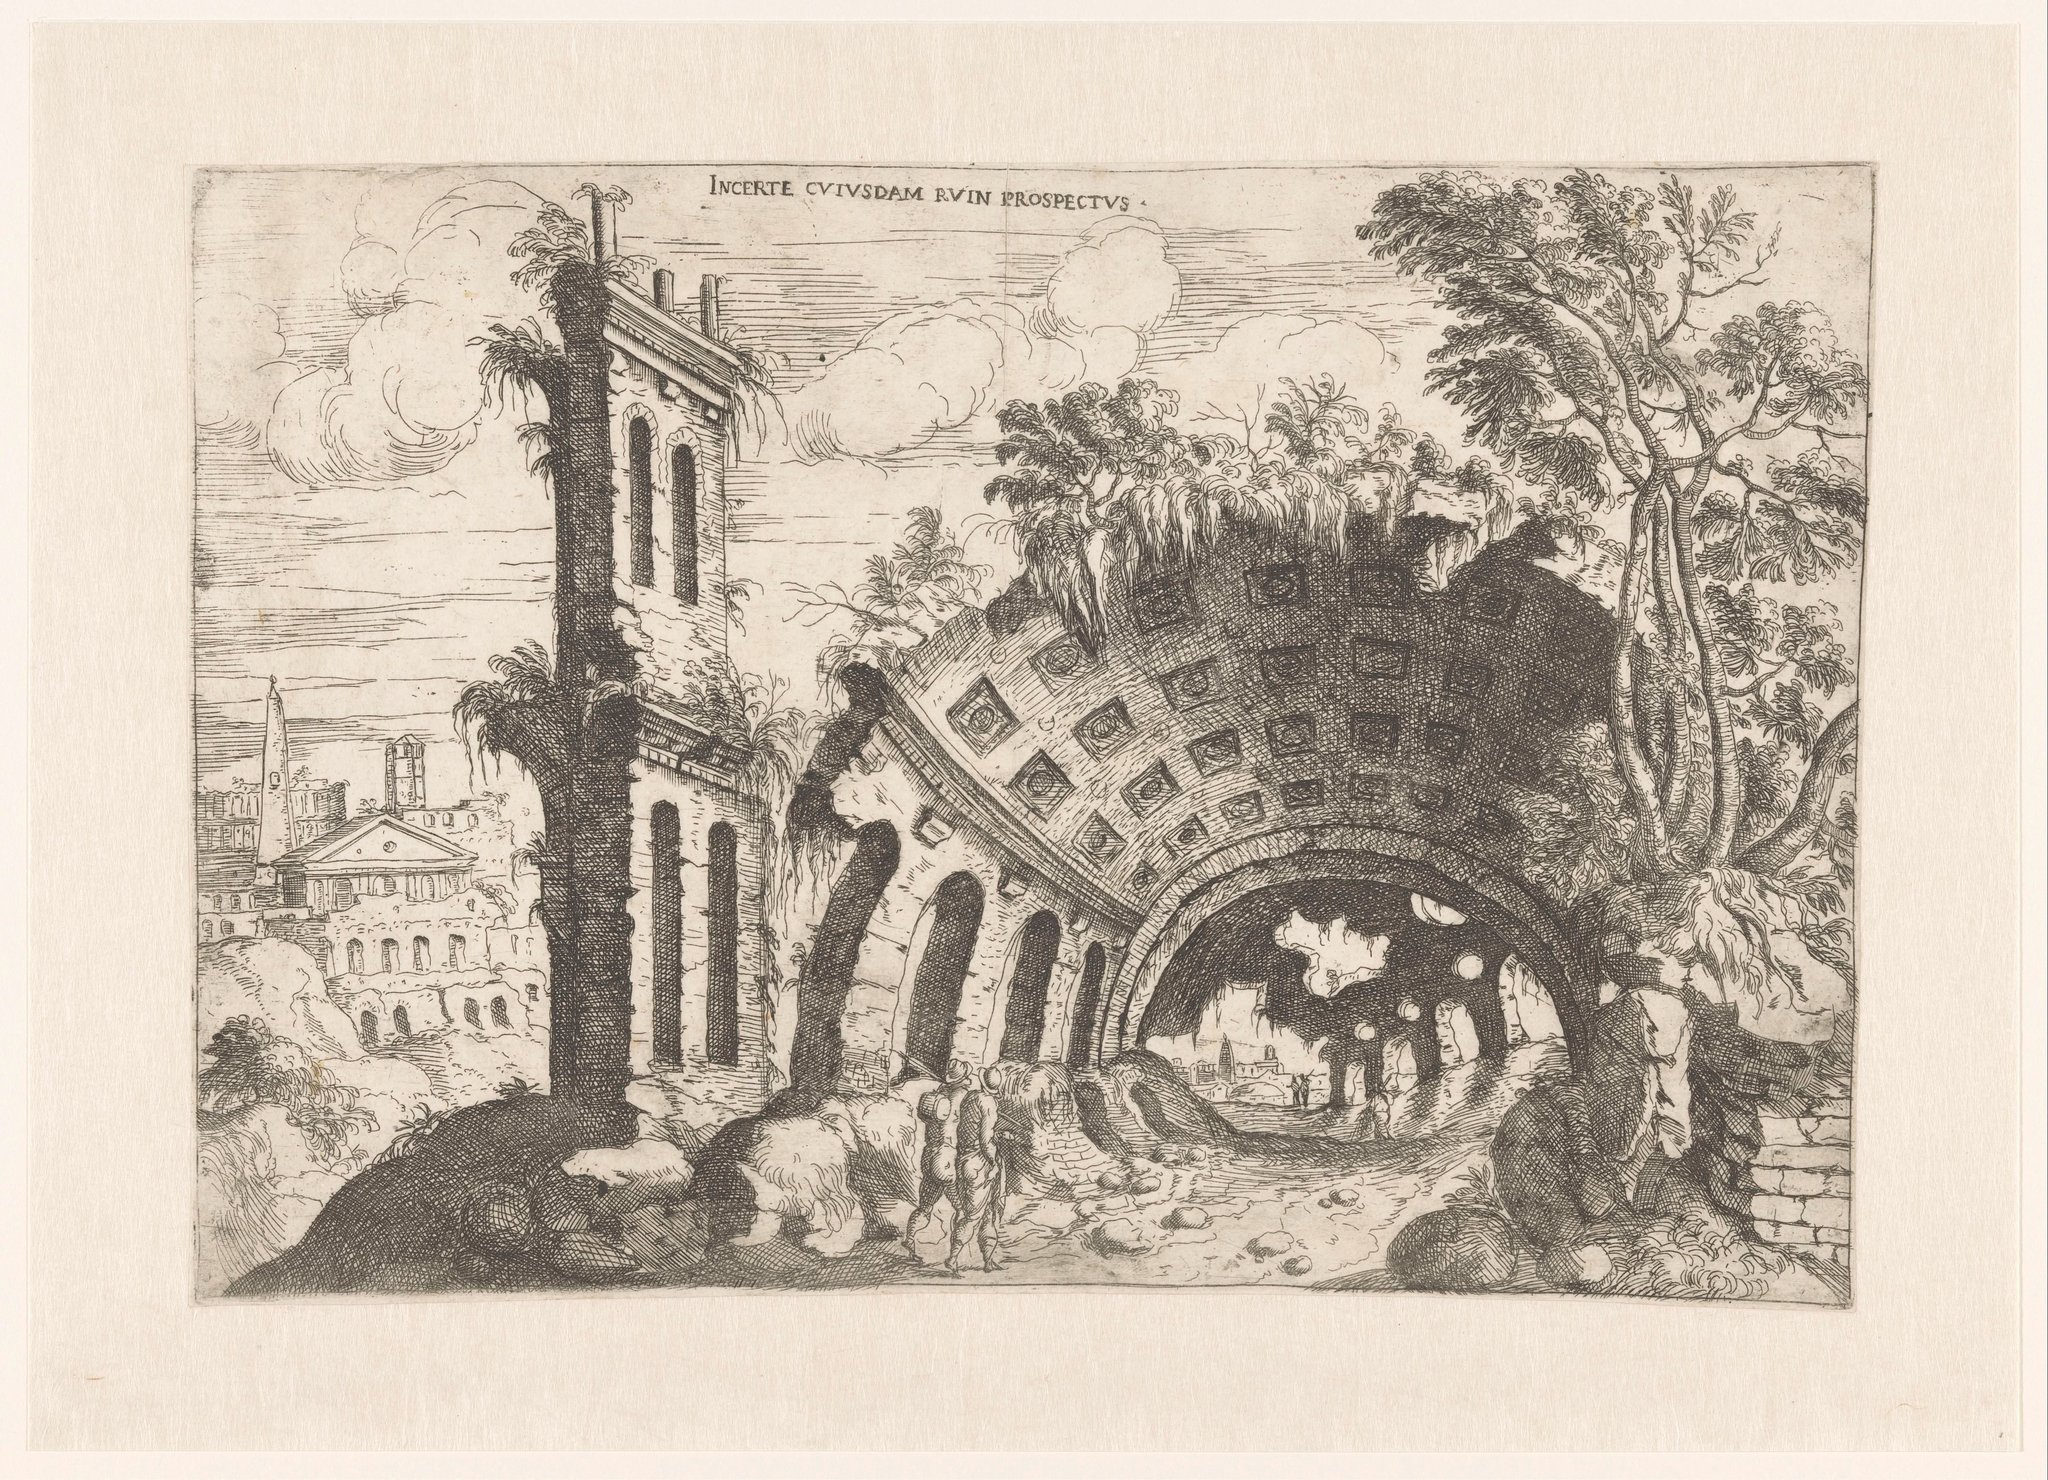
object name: book illustration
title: Incerte cuiucdam ruin prospectus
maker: giovanni battista pittoni (i)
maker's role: print maker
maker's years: 1520-1583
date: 1561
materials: paper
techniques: etching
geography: vicenza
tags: ruin of a building ~ architecture, landscape with ruins, landscape with ruins (+ city(-scape) with figures, staffage)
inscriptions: collector's mark: Lugt 2760, collector's mark: Lugt 2228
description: Deze prent maakt deel uit van een reeks illustraties voor het traktaat van Vincenzo Scamozzi 'Discorsi sopra le antichità di Roma', Venetië 1582. De prenten zijn vrije kopieën naar een serie prenten van Hieronymus Cocks die voor het eerst werd uitgegeven in 1551 (Hollstein 22-47).